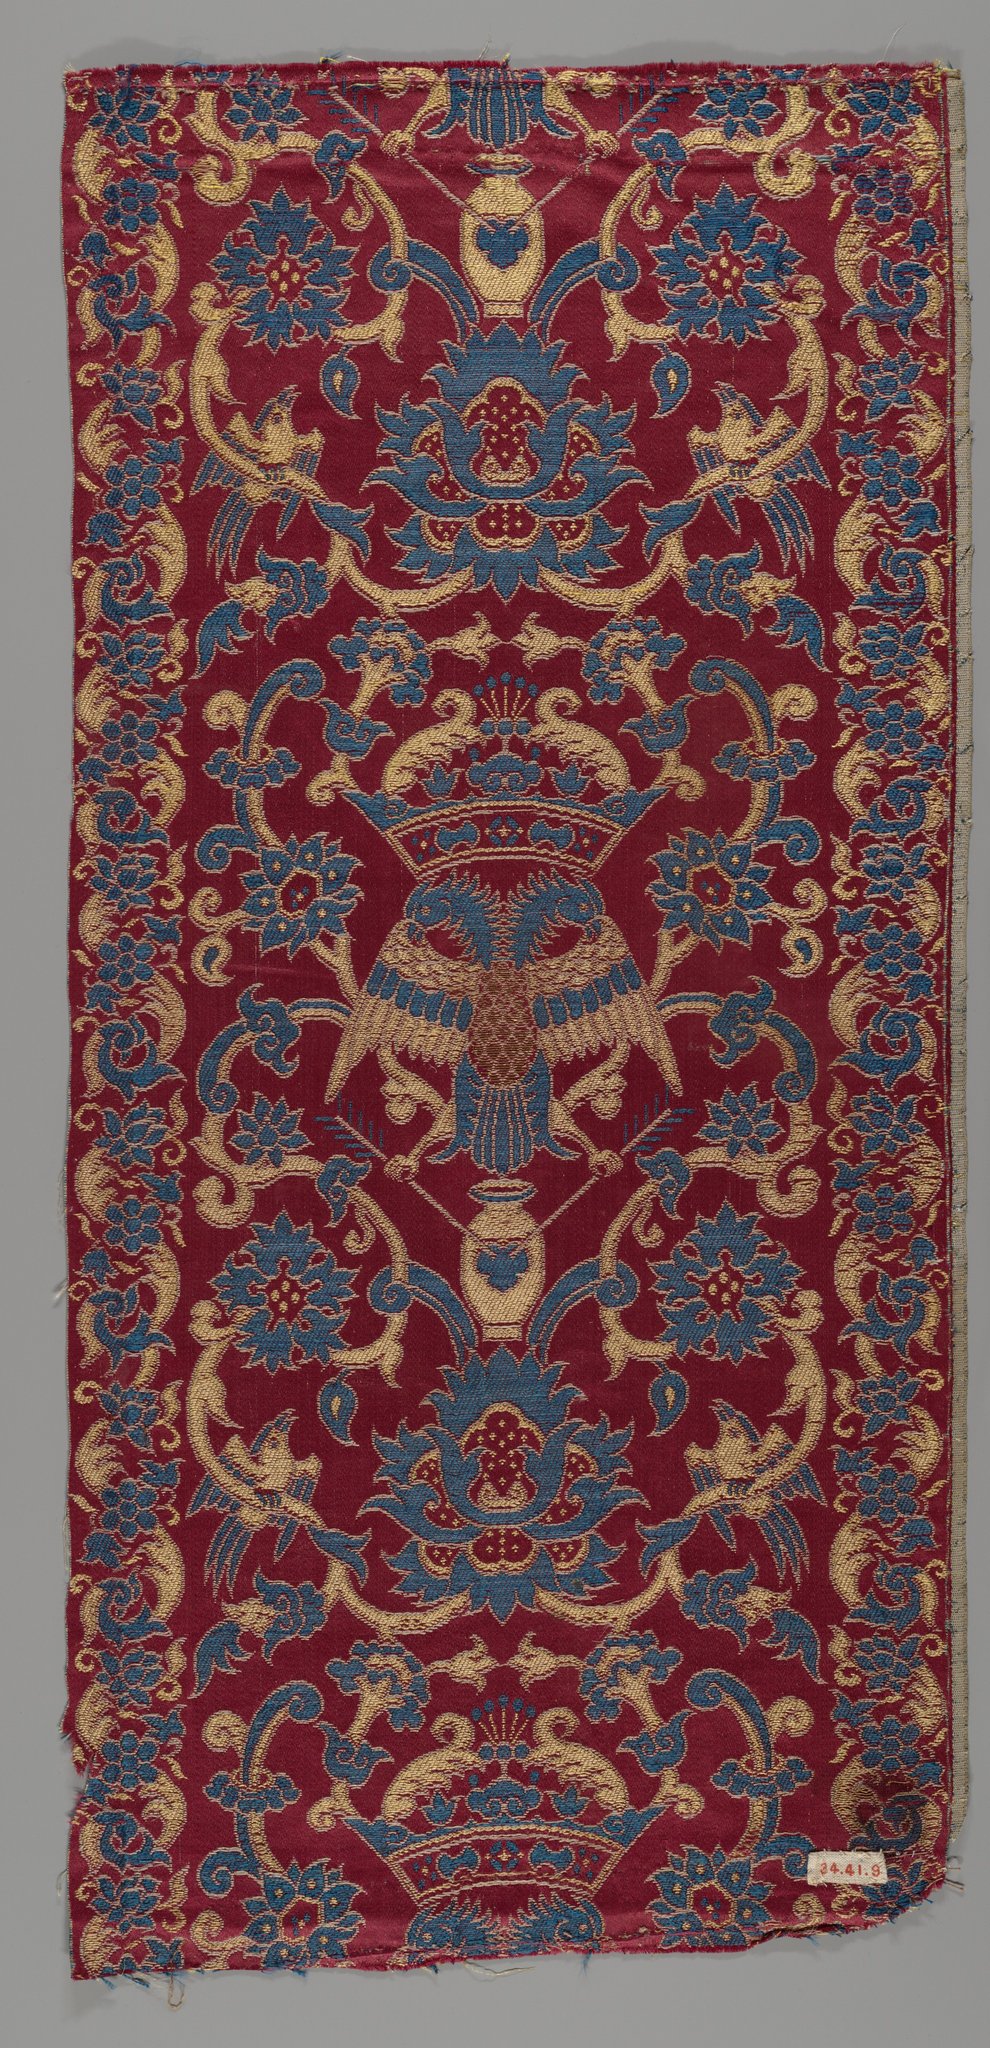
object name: piece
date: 1551-1600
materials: metal thread, silk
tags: birds